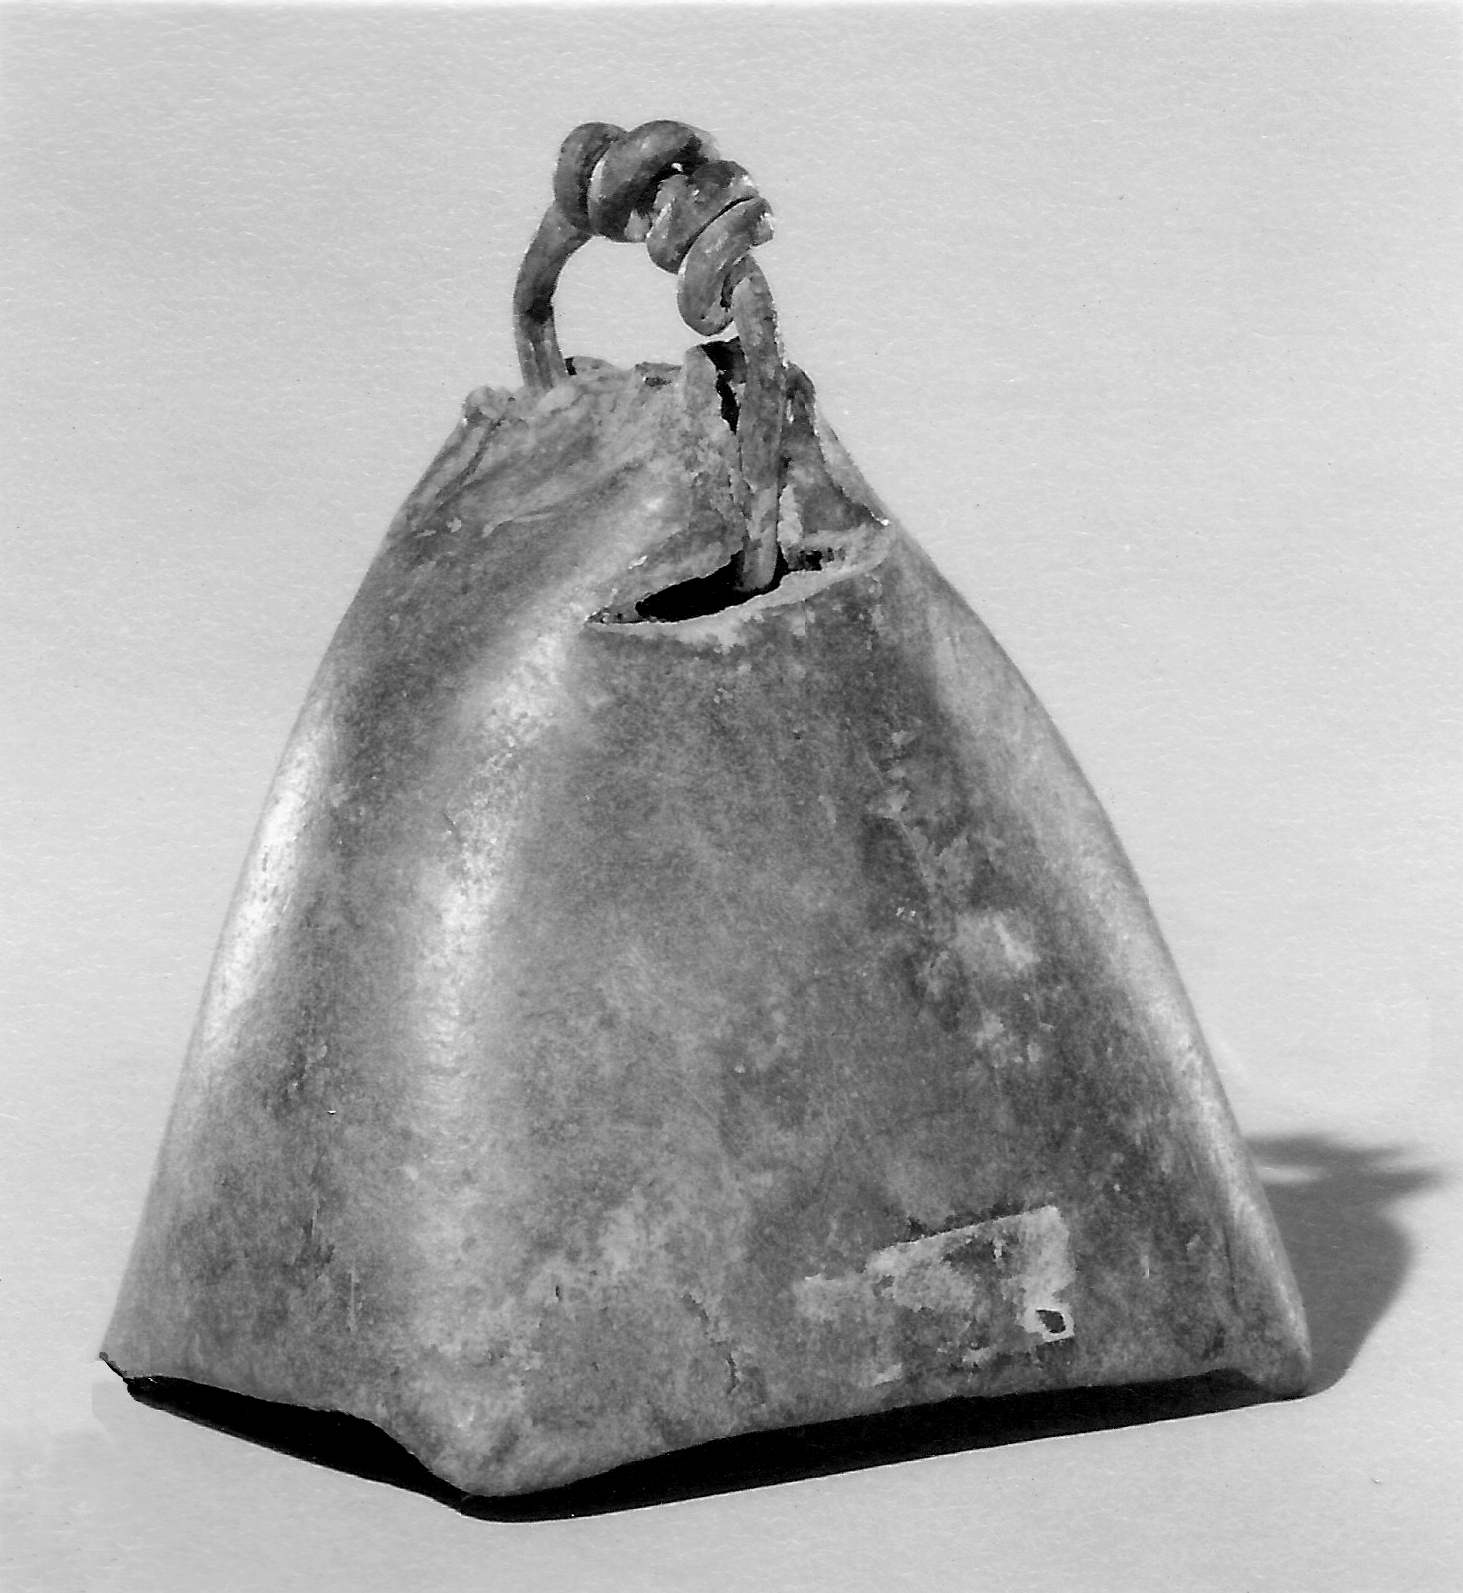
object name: bell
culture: italian, roman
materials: metal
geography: italy